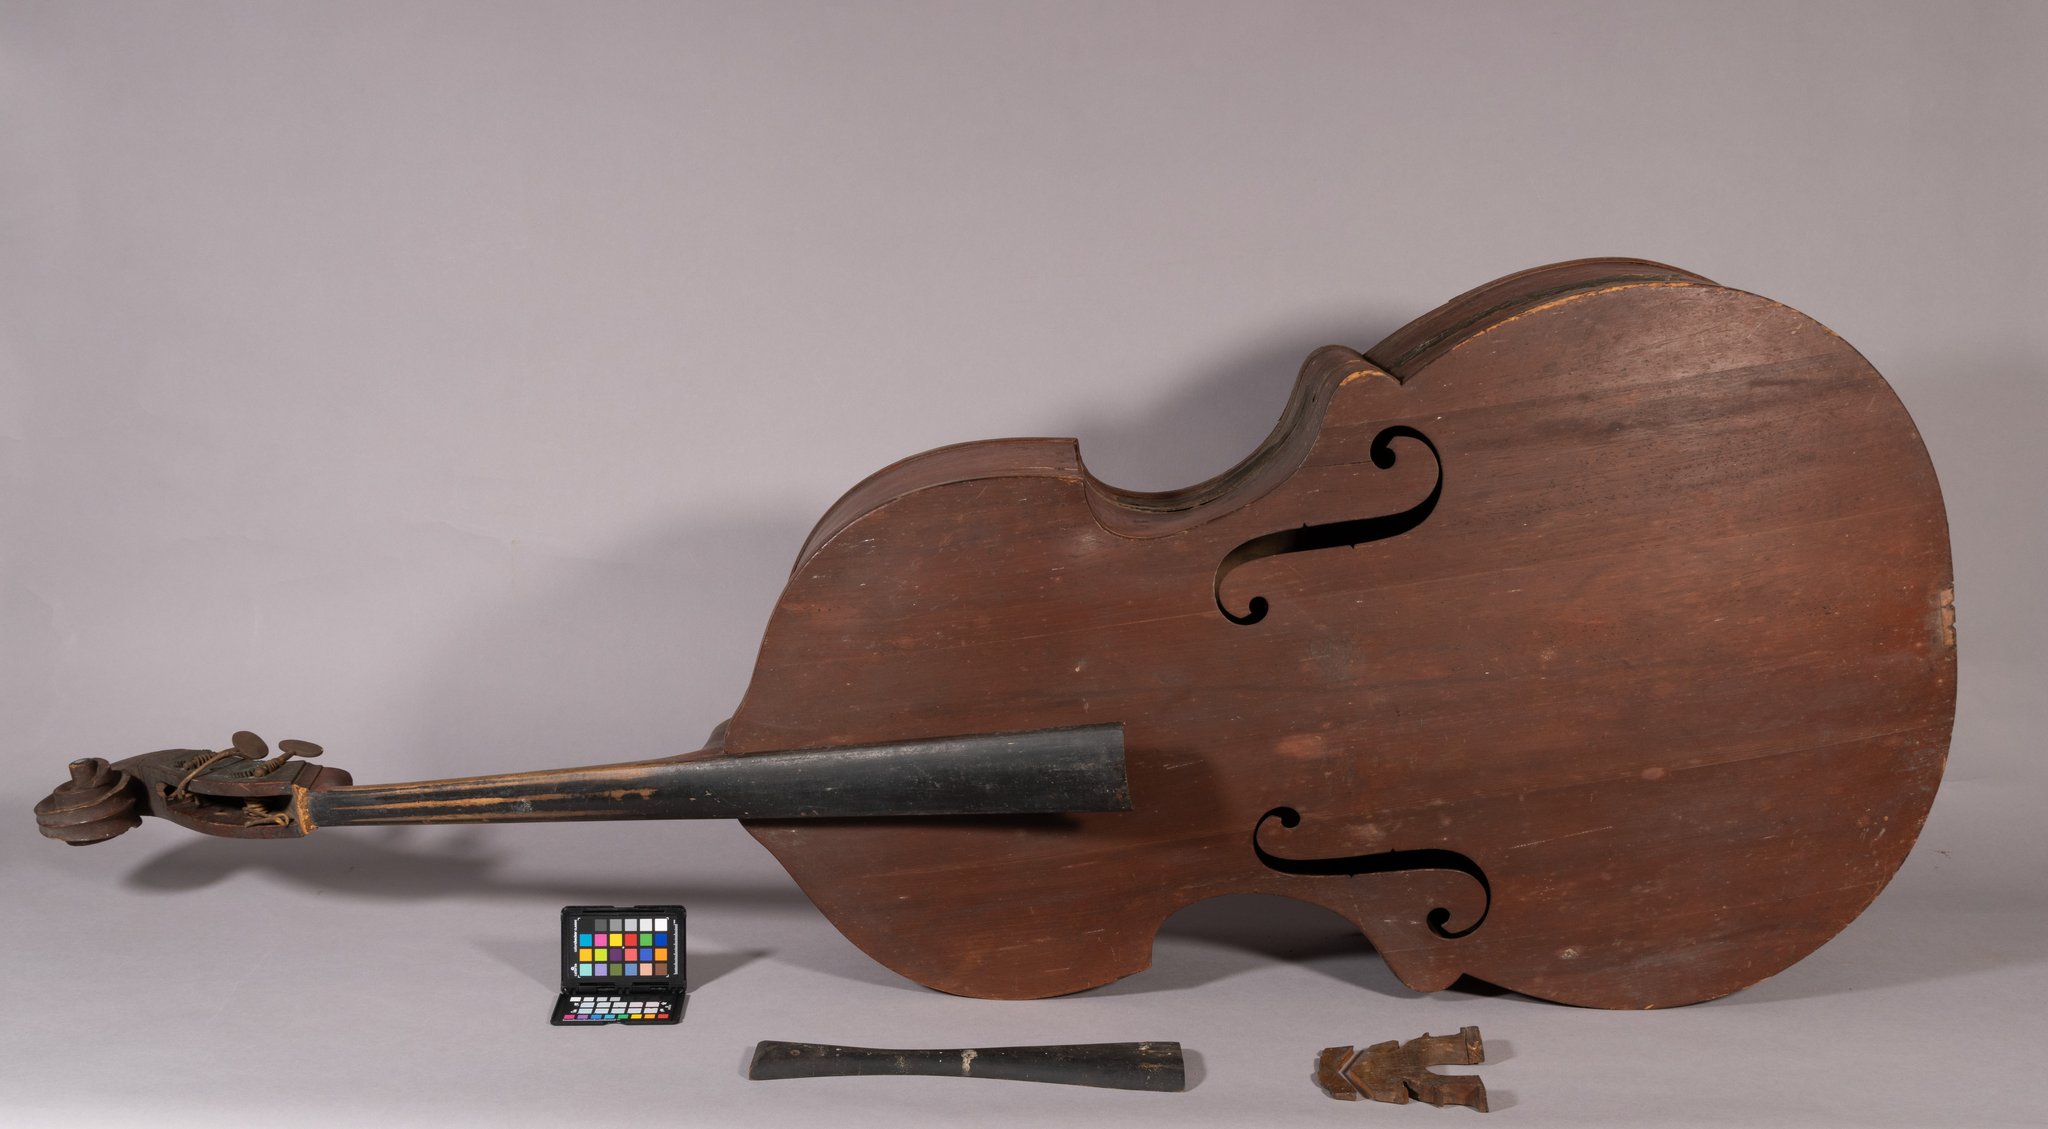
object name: bass viol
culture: american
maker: abraham prescott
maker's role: maker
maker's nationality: american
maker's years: 1789-1858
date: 1820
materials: wood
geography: united states